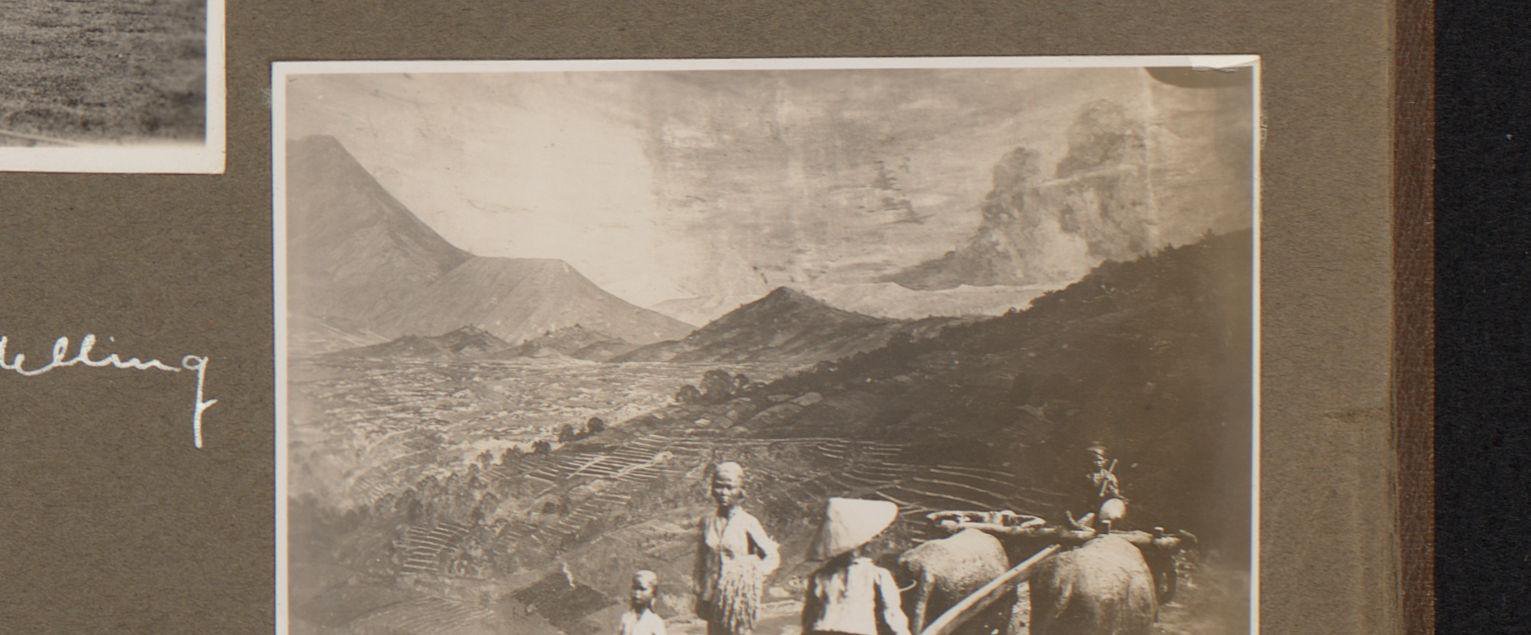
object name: album leaf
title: Diorama op de Indische Tentoonstelling, Den Haag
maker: Anonymous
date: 1932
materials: paper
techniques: gelatin silver print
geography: the hague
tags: diorama, sawahs, rice paddies, dutch east indies, the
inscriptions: inscription: ‘Diorama v. Eland’